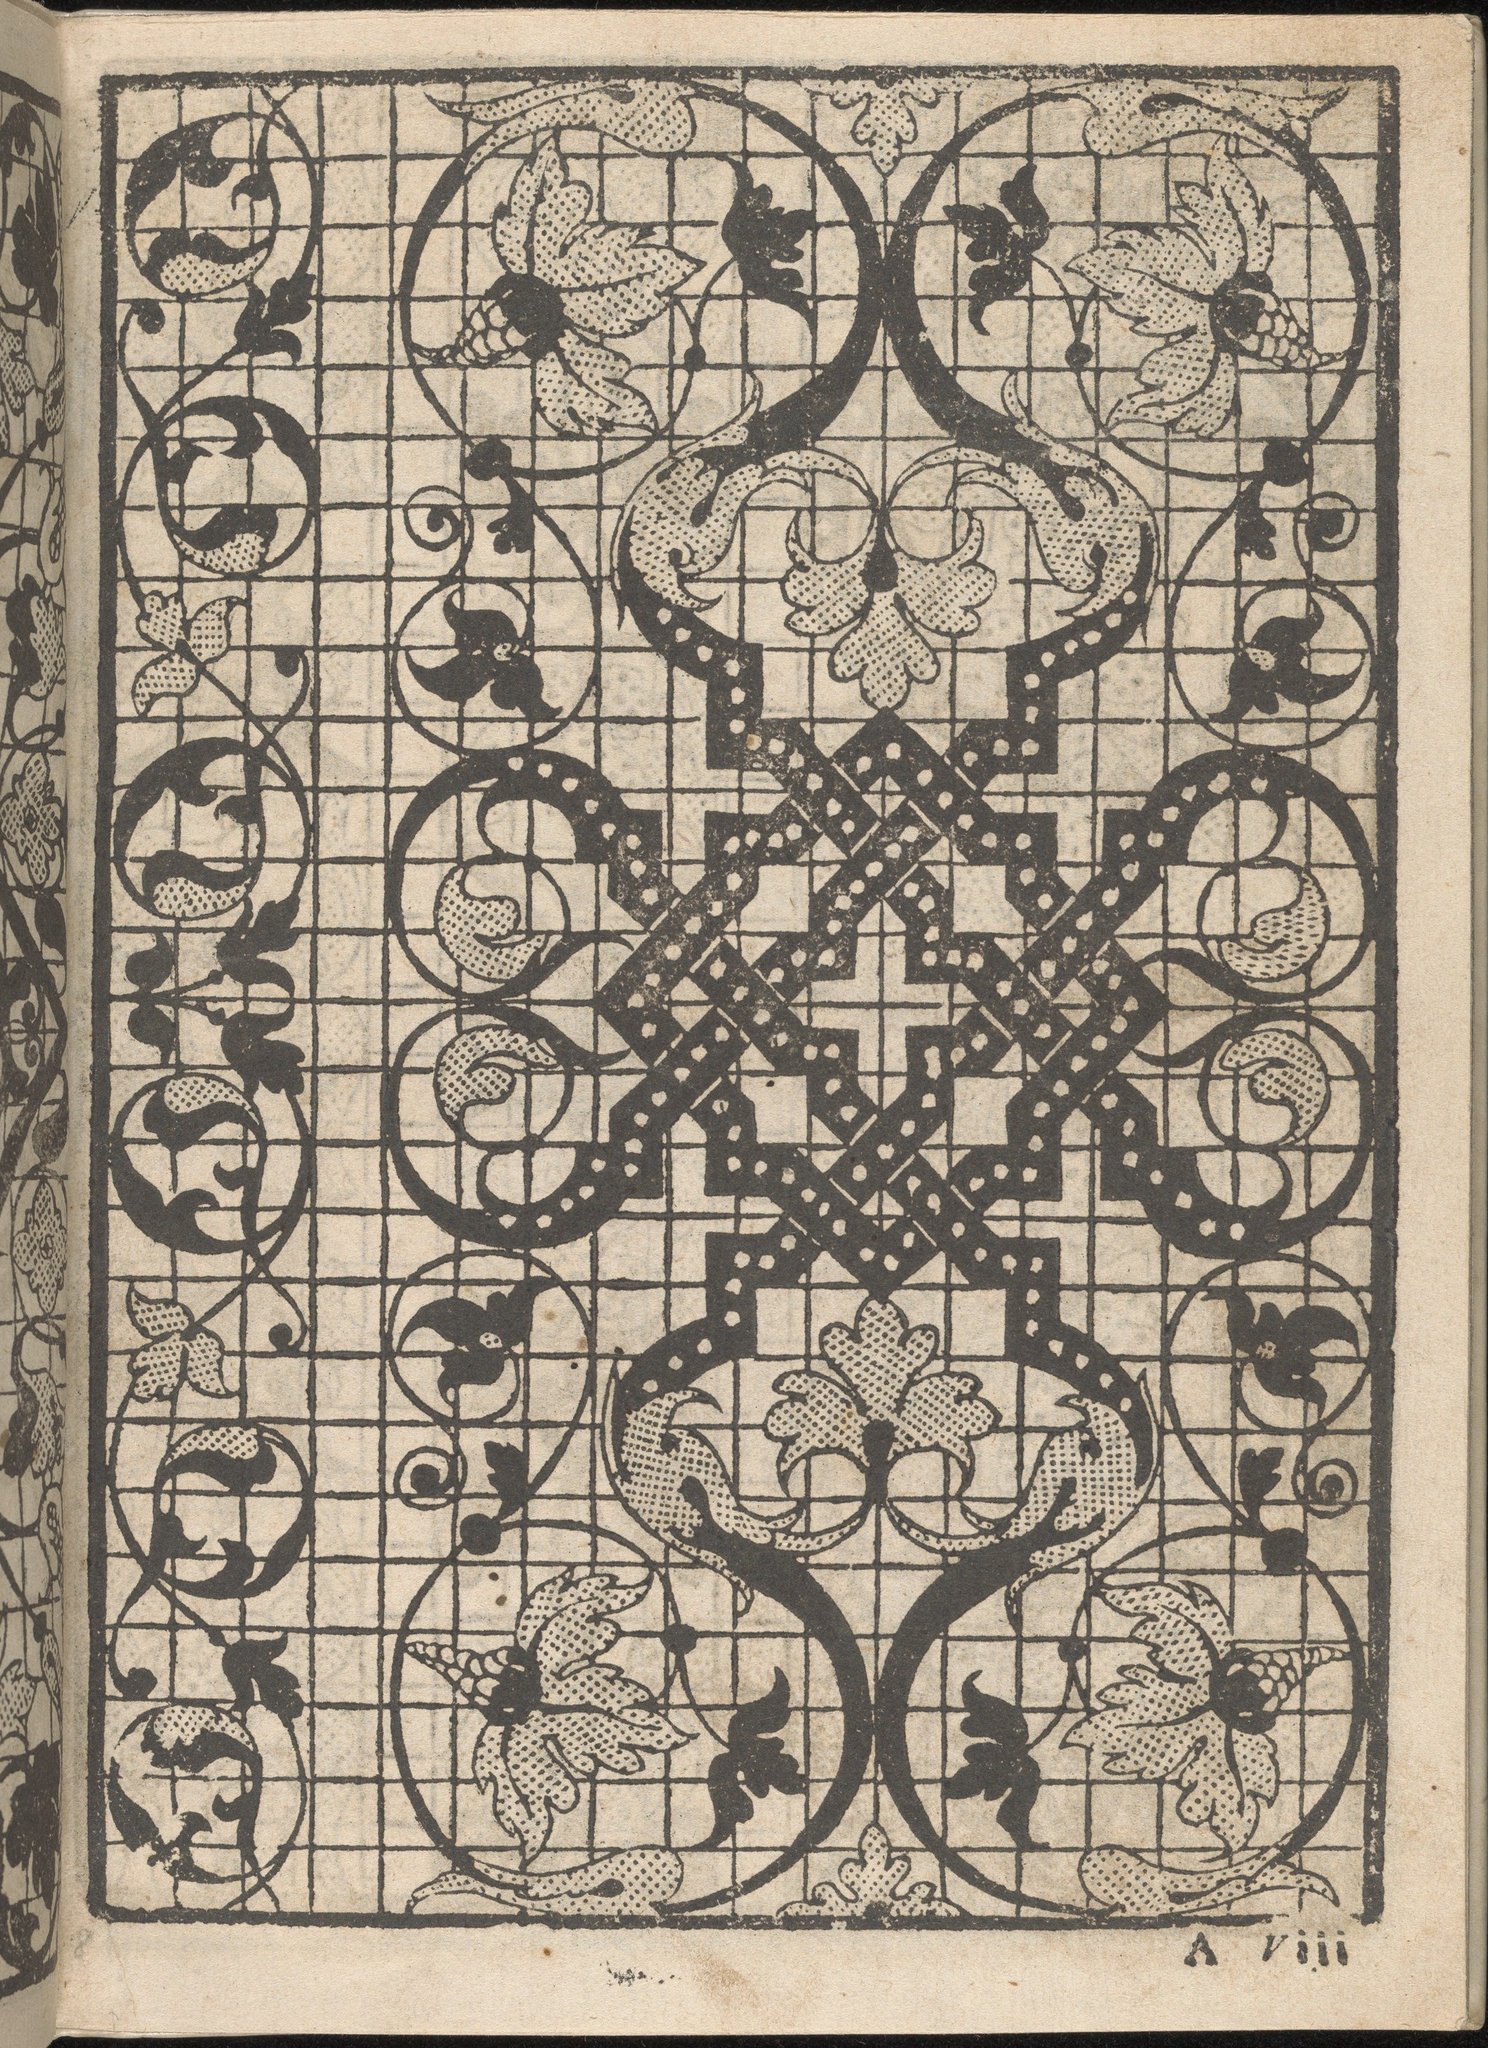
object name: book print ornament architecture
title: Splendore delle virtuose giovani, page 4 (verso)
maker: iseppo foresto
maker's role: designer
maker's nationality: italian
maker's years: 1520-1580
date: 1564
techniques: woodcut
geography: italy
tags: ornament